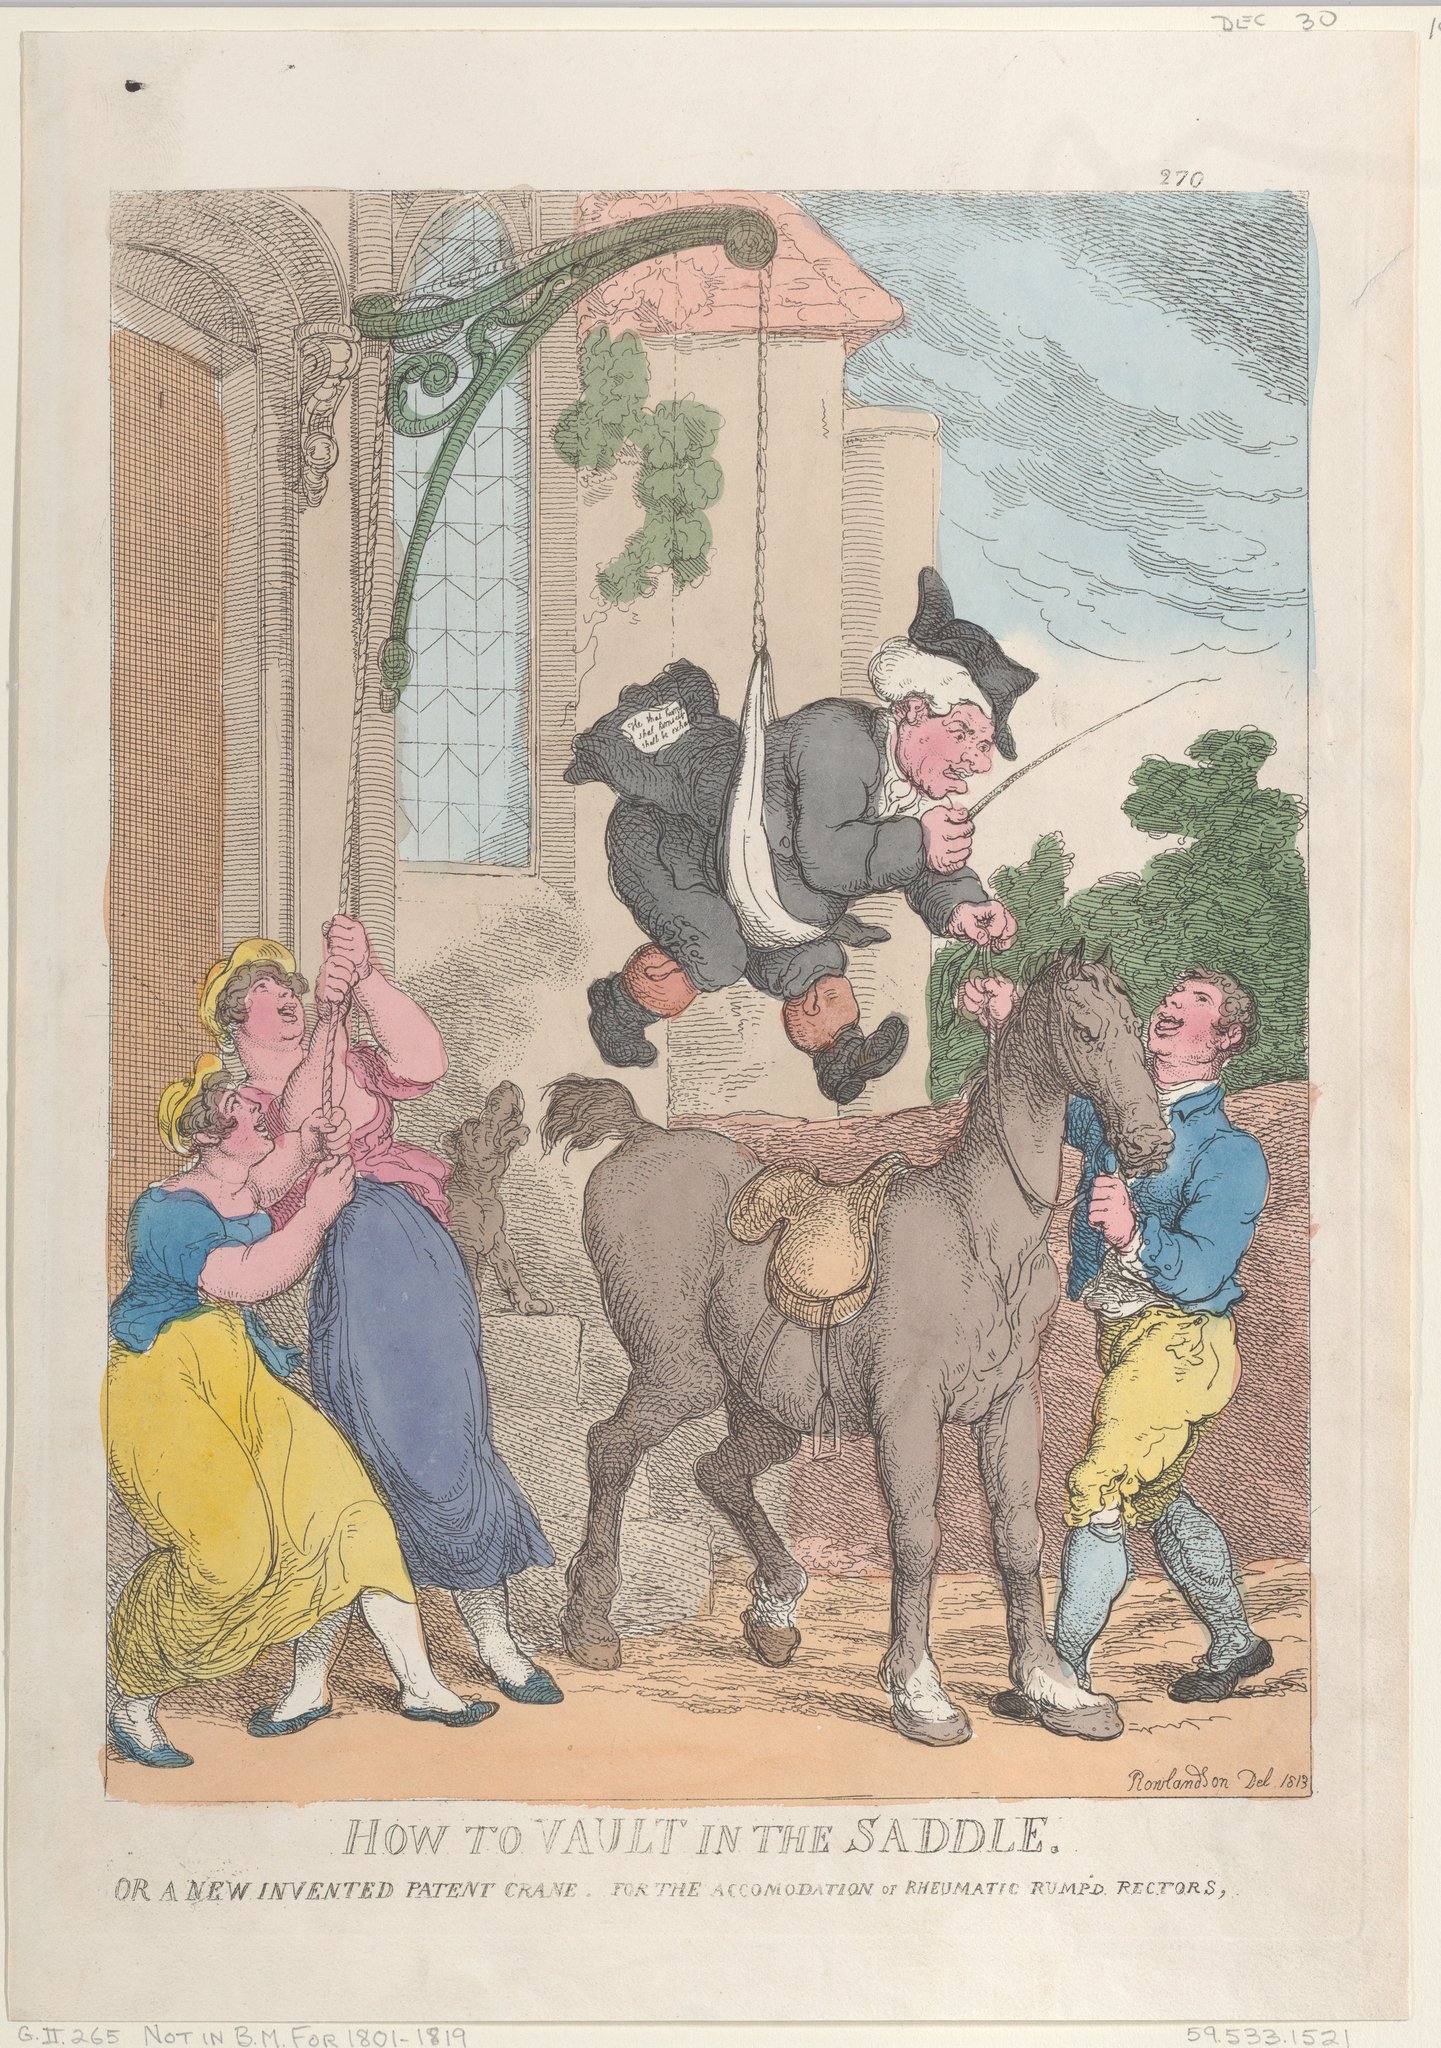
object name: print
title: How to Vault in the Saddle or a New Invented Patent Crane for the Accomodation or Rheumatic Rump'd Rectors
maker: thomas rowlandson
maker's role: artist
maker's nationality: british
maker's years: 1757-1827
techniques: etching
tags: satire,men,women,horses